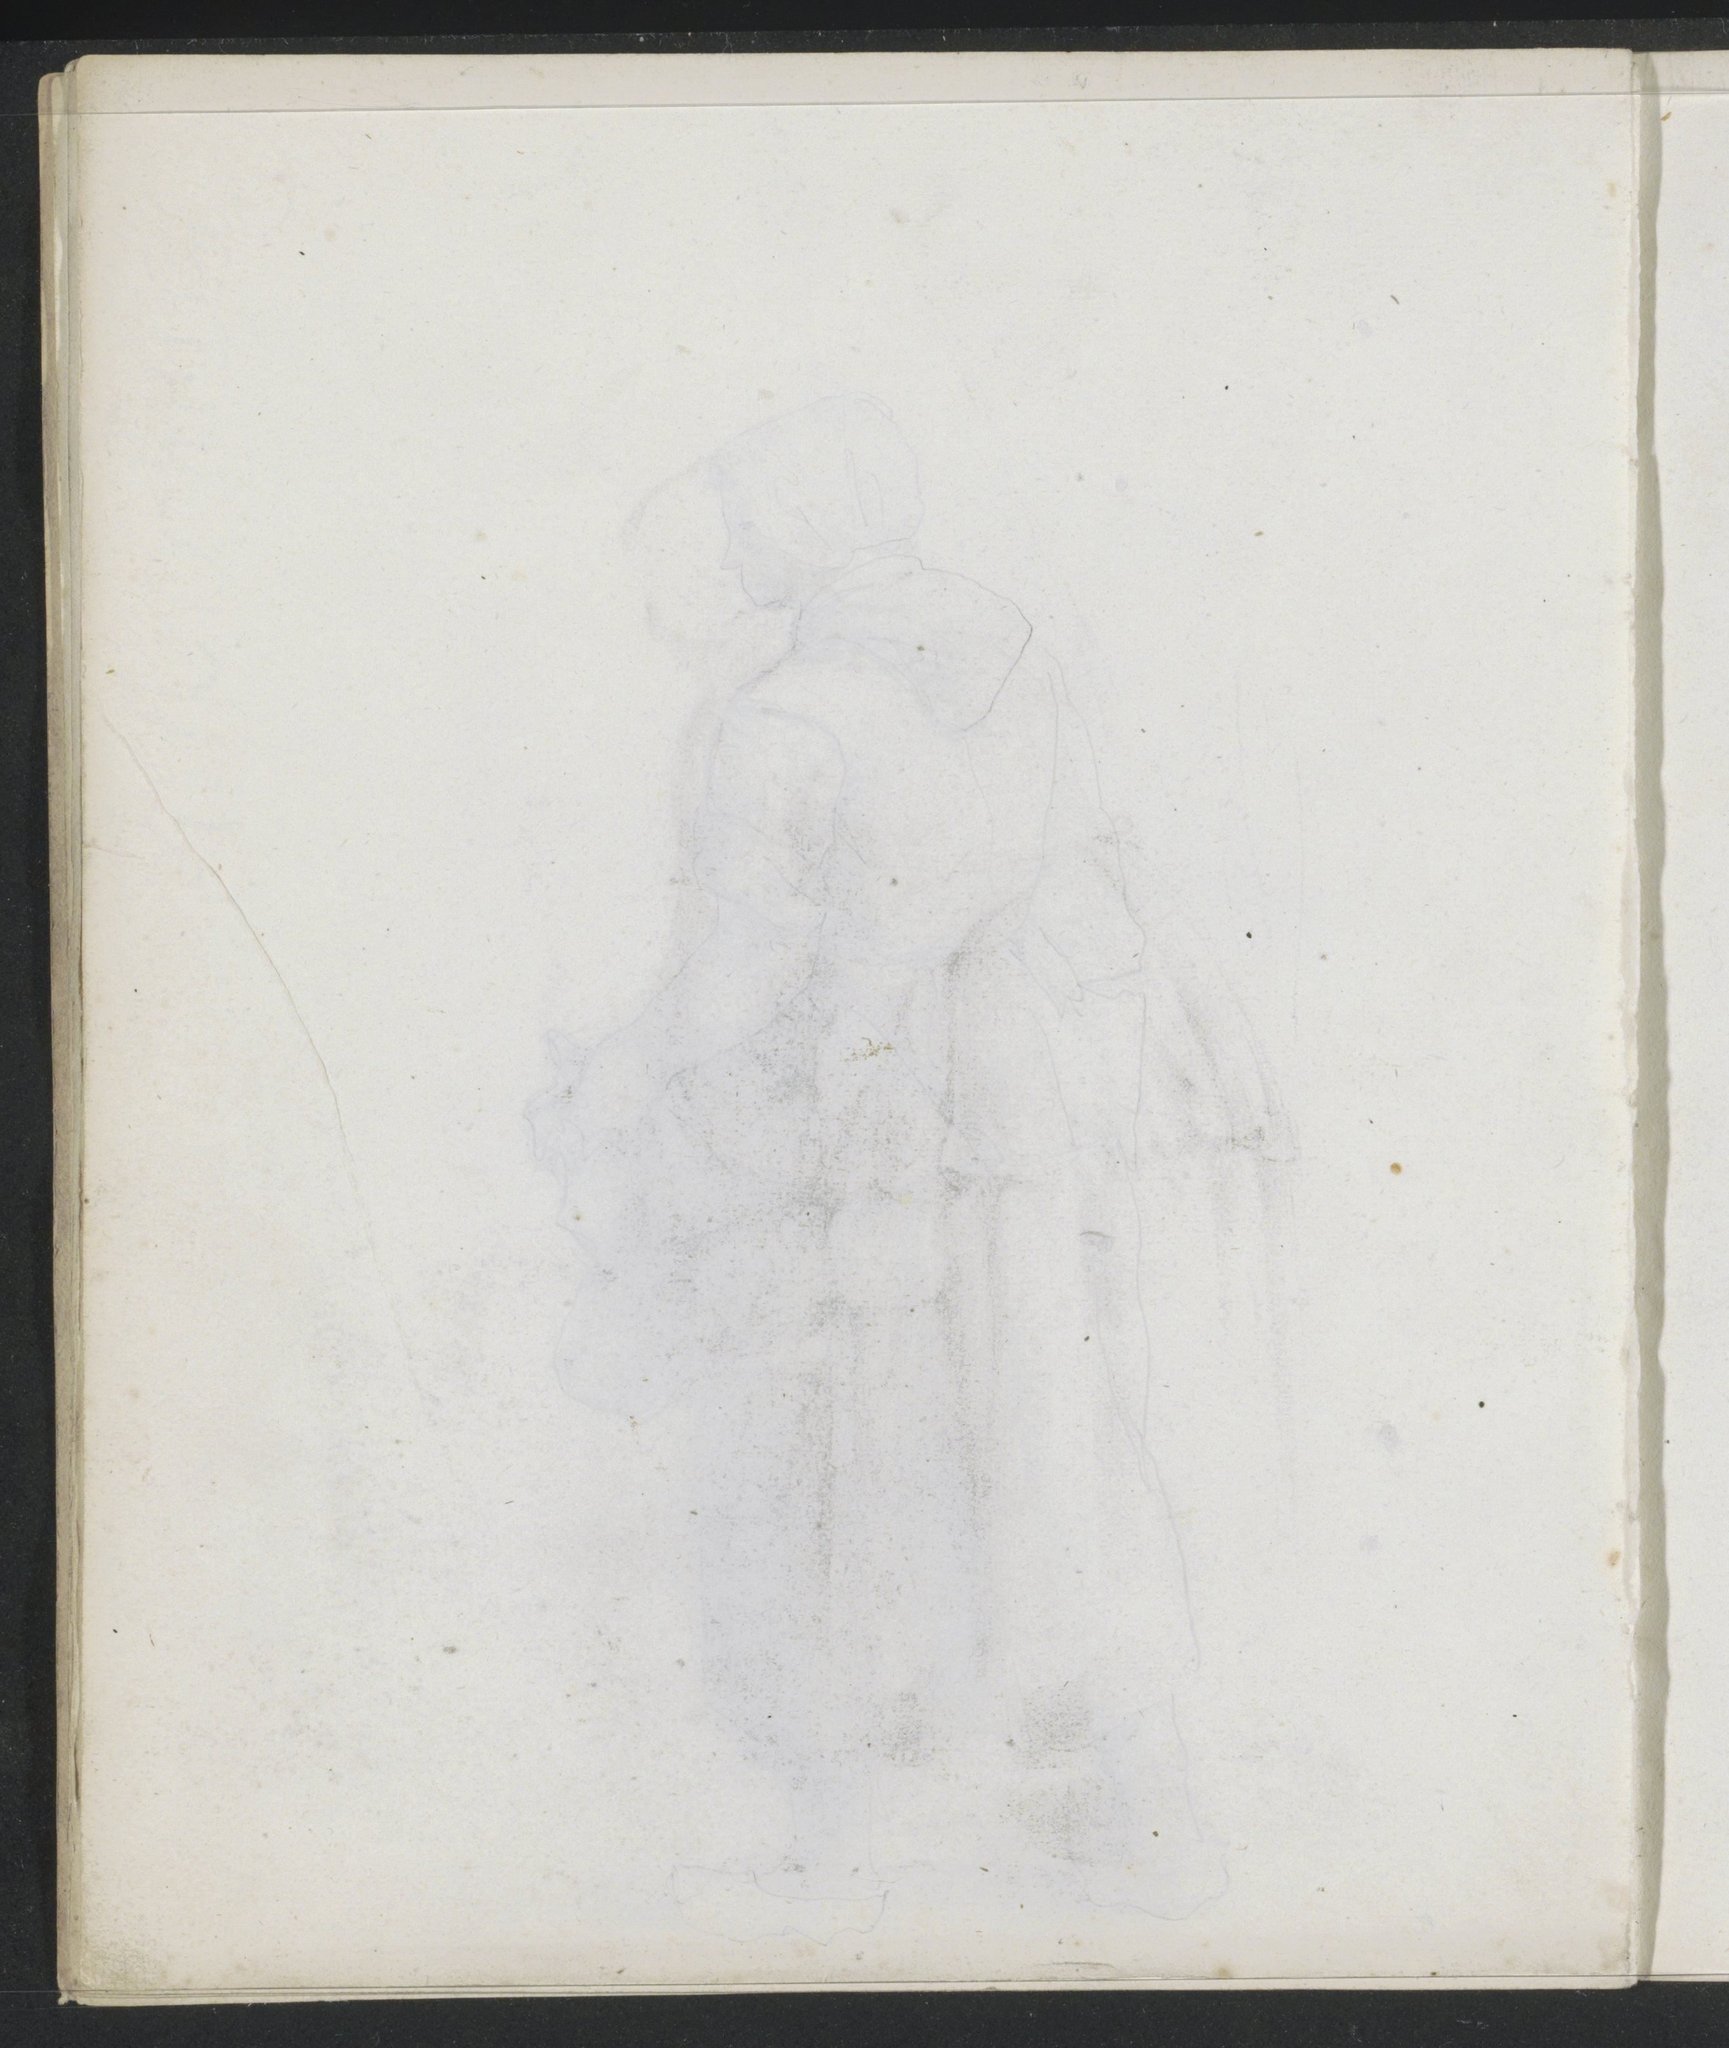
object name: sketchbook leaf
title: Overgetrokken tegendruk van blad 7 recto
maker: balthasar paul ommeganck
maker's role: draughtsman, painter, print maker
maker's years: 1755-1826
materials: paper, pencil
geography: antwerp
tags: farmers - aa - female farmer, farmer's wife, carrying something in basket, bag, rucksack, etc.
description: Boerin met een zak, overgetrokken van de tegendruk op blad 7 recto. Blad 7 verso uit een schetsboek met 8 bladen.